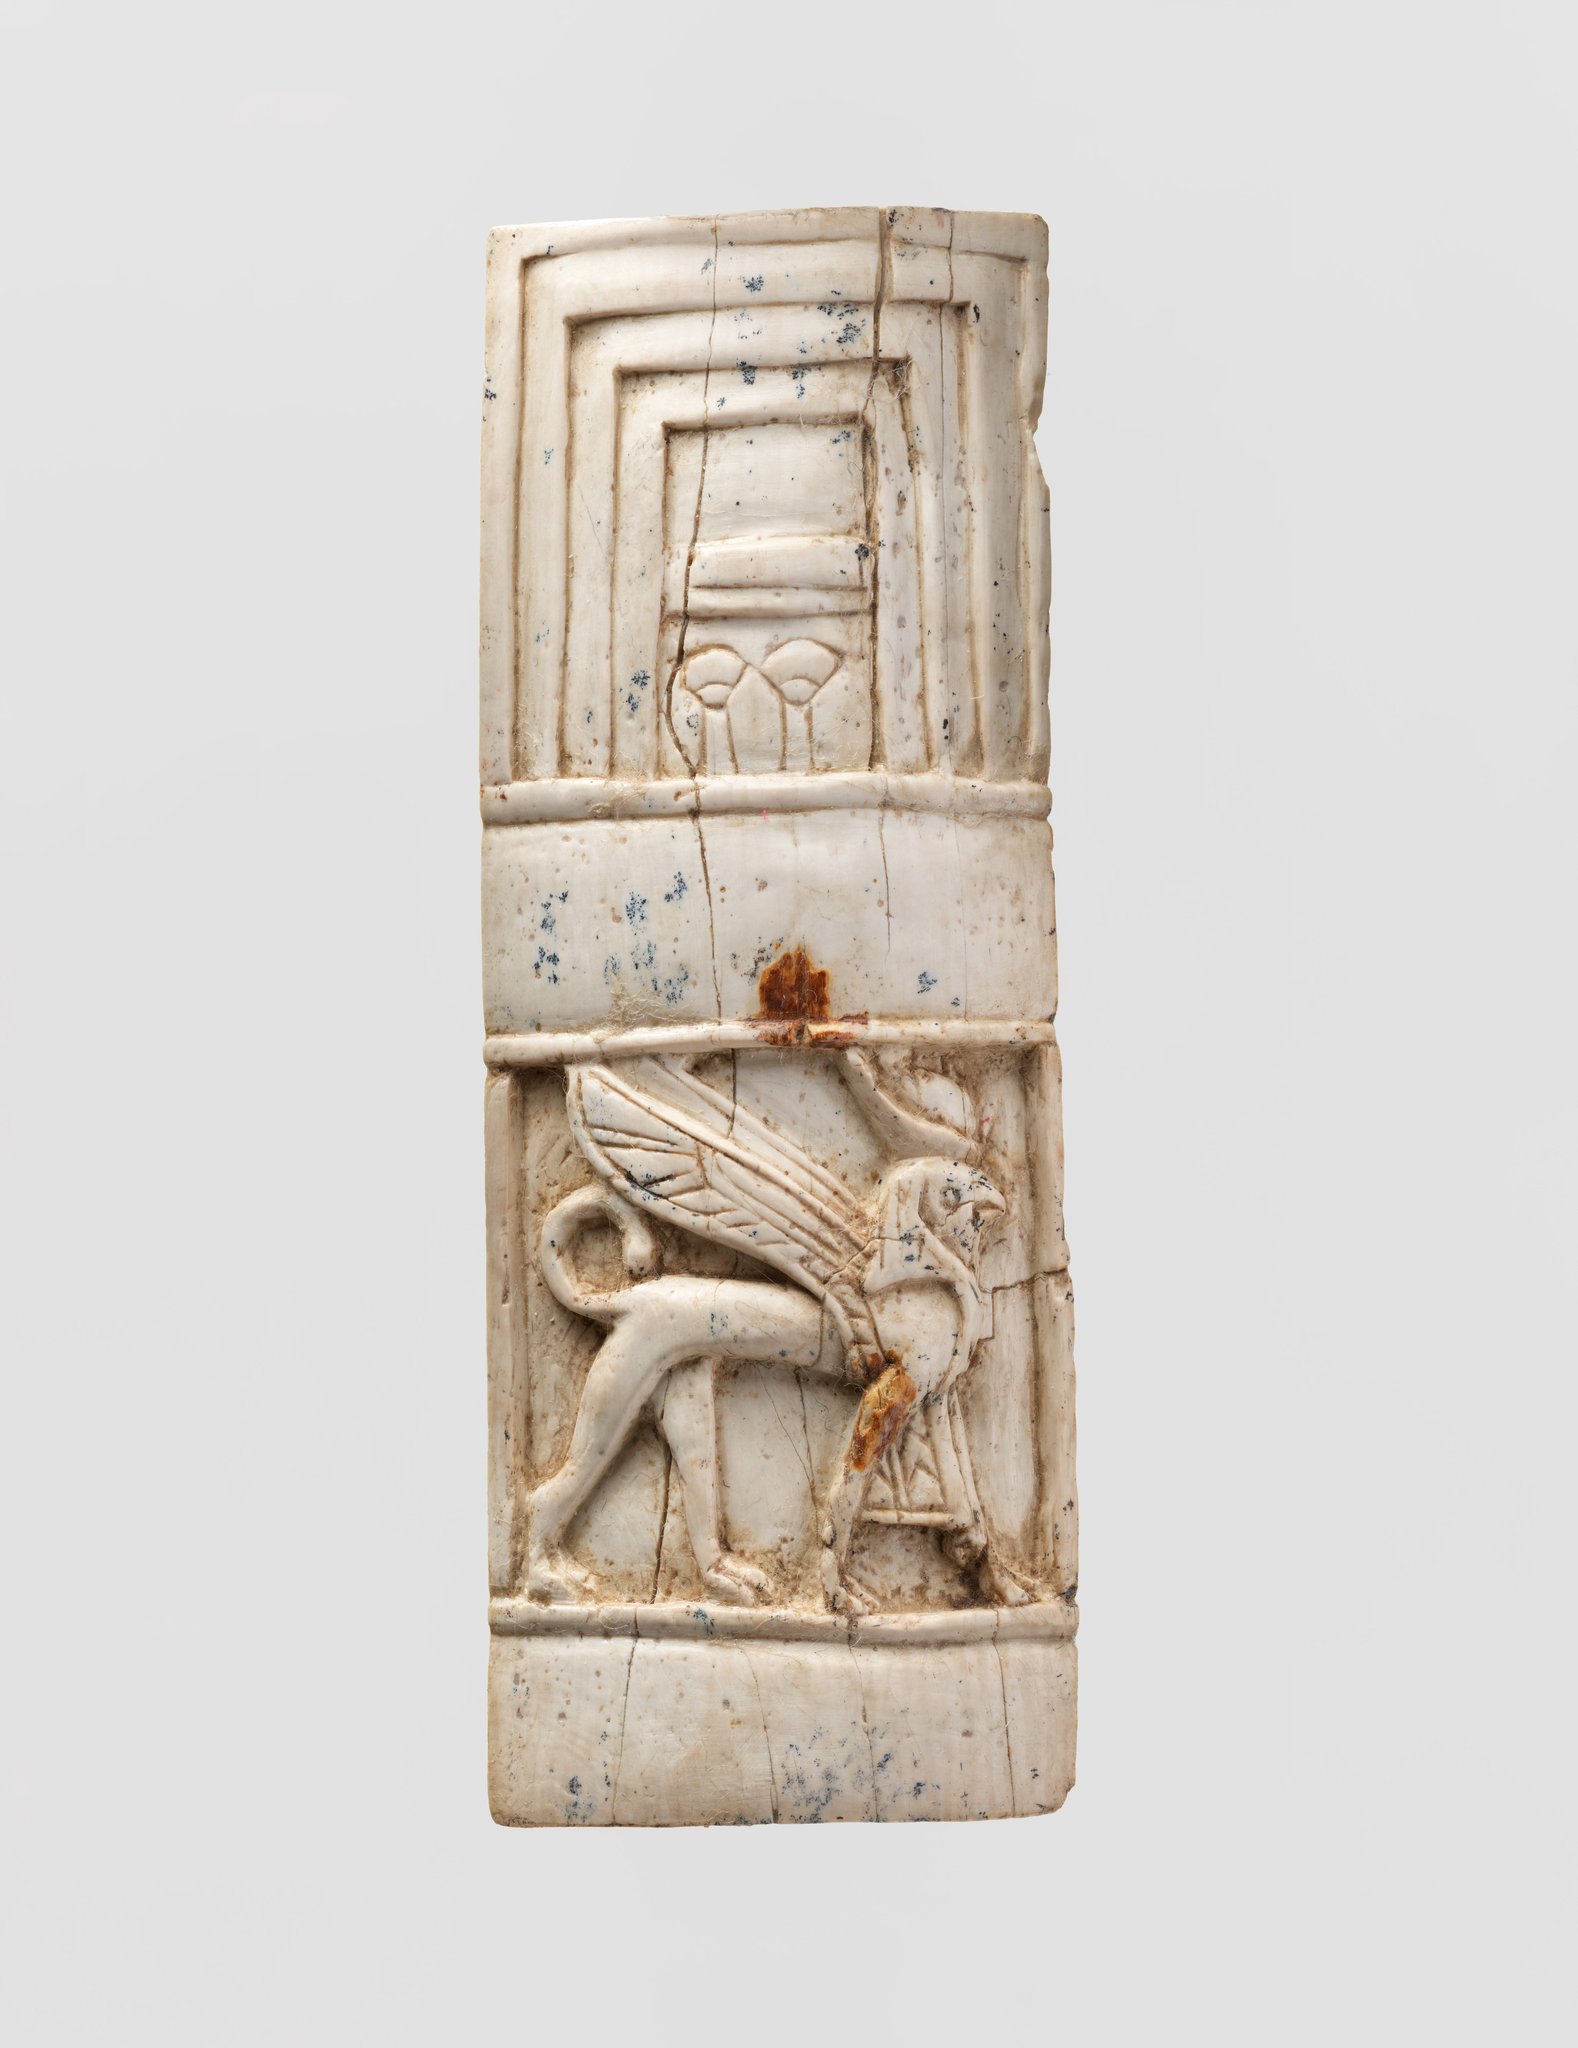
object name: relief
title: Furniture plaque carved in relief with window and sphinx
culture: assyrian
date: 800-601 BCE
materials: ivory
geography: mesopotamia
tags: sphinx